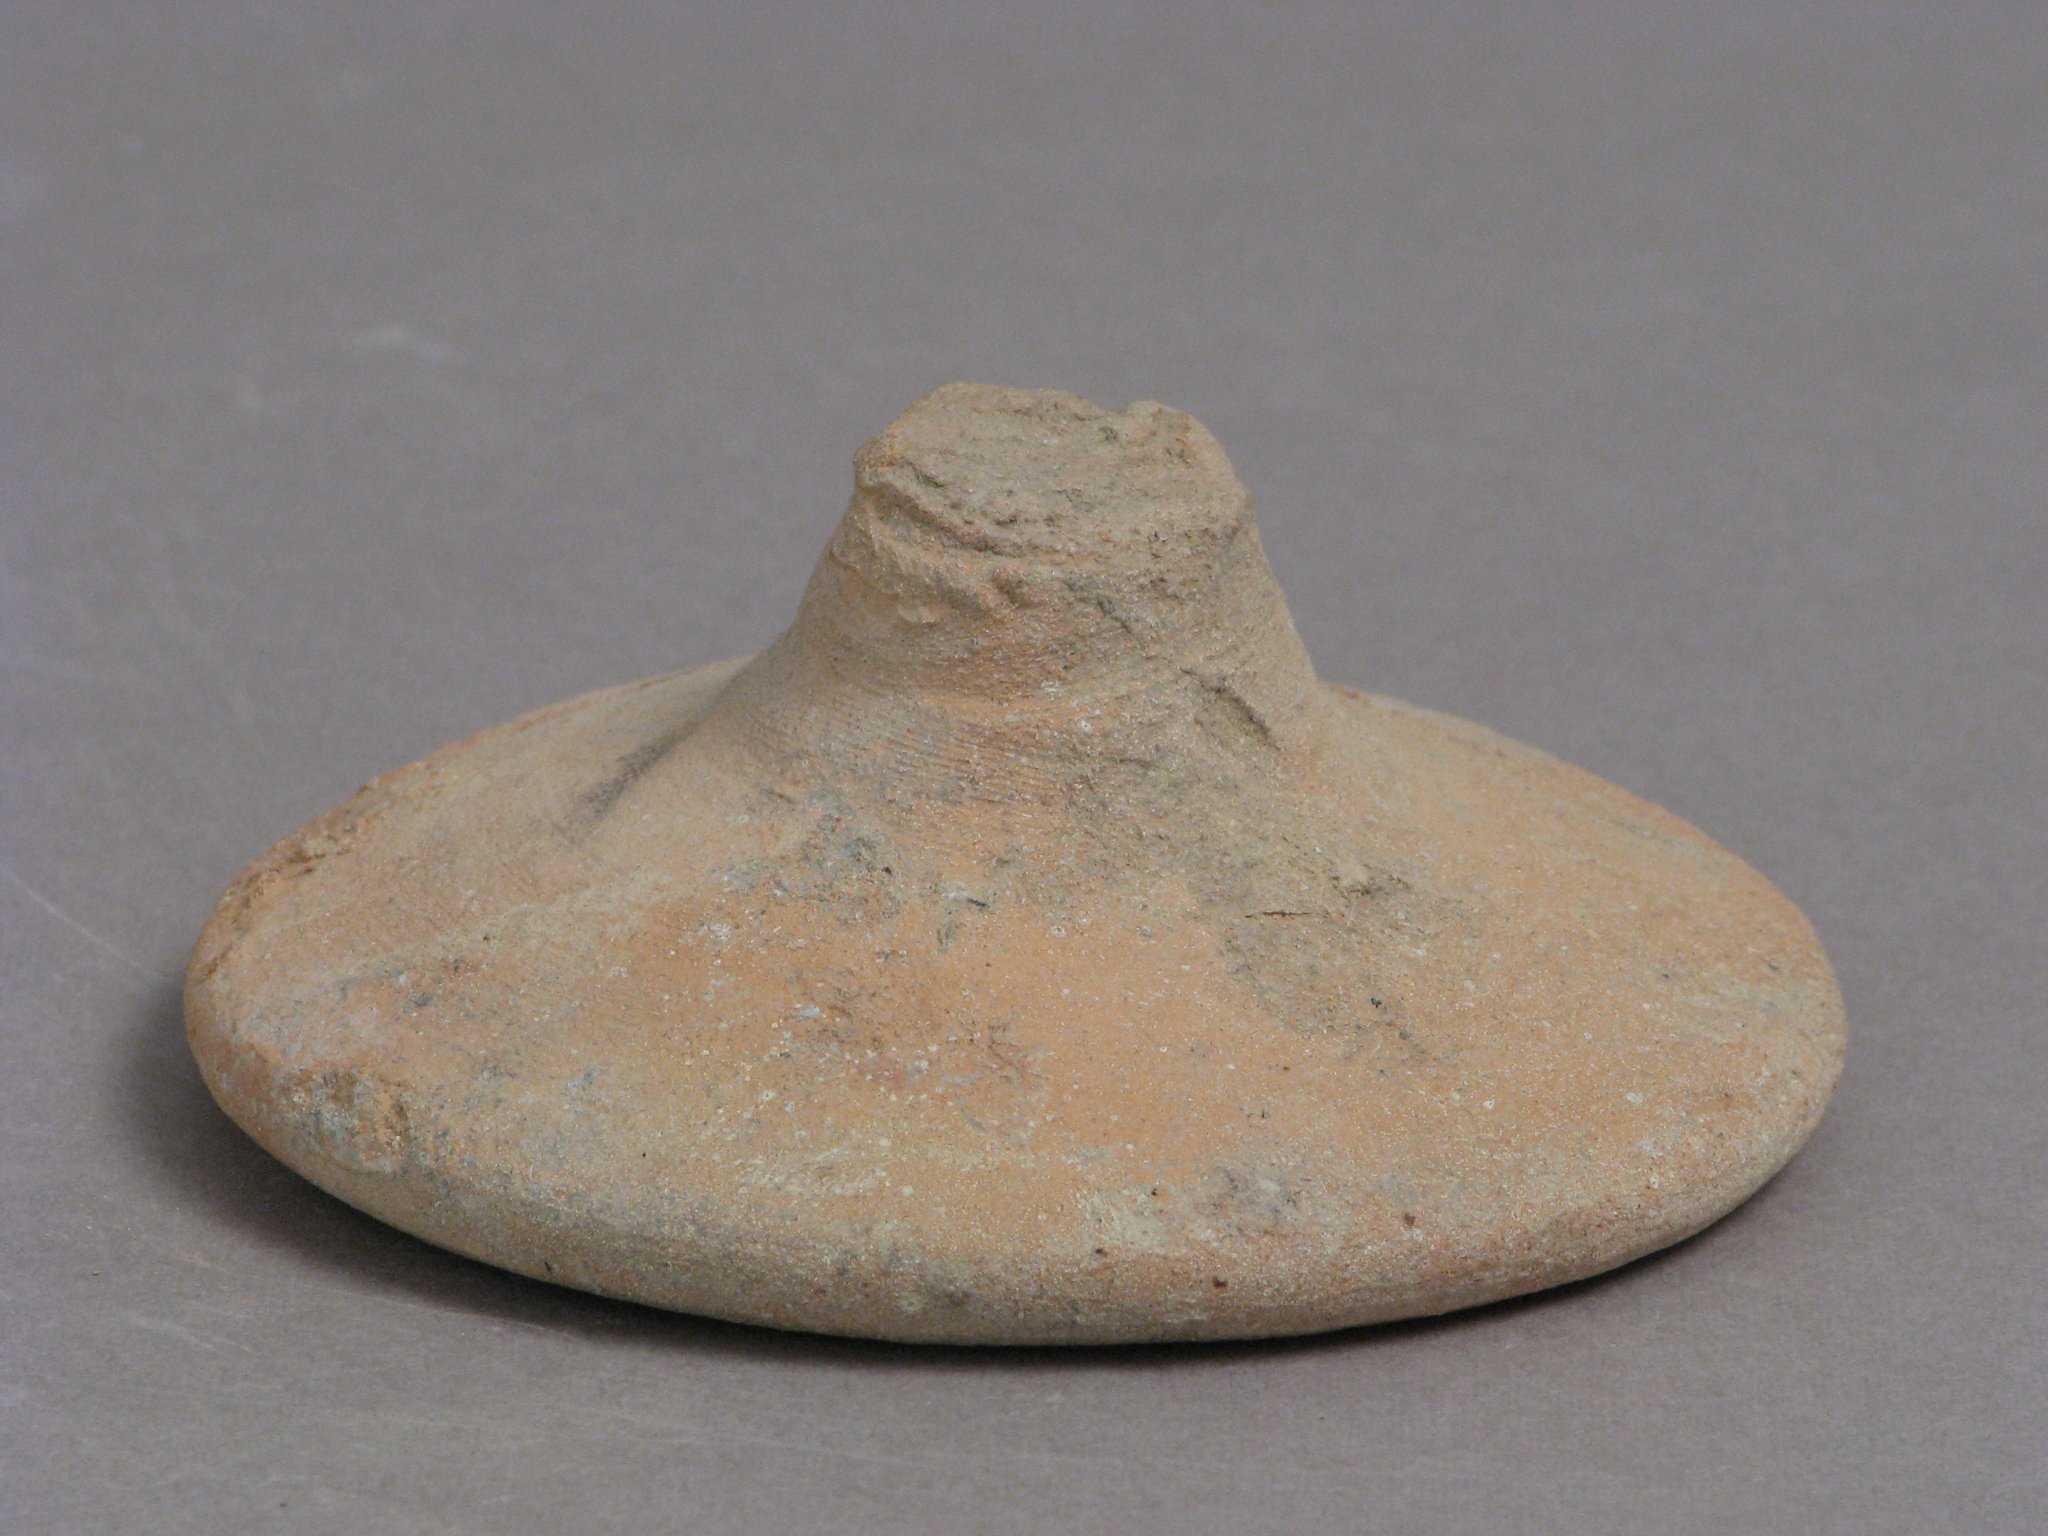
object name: lid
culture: coptic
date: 301-700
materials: earthenware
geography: egypt